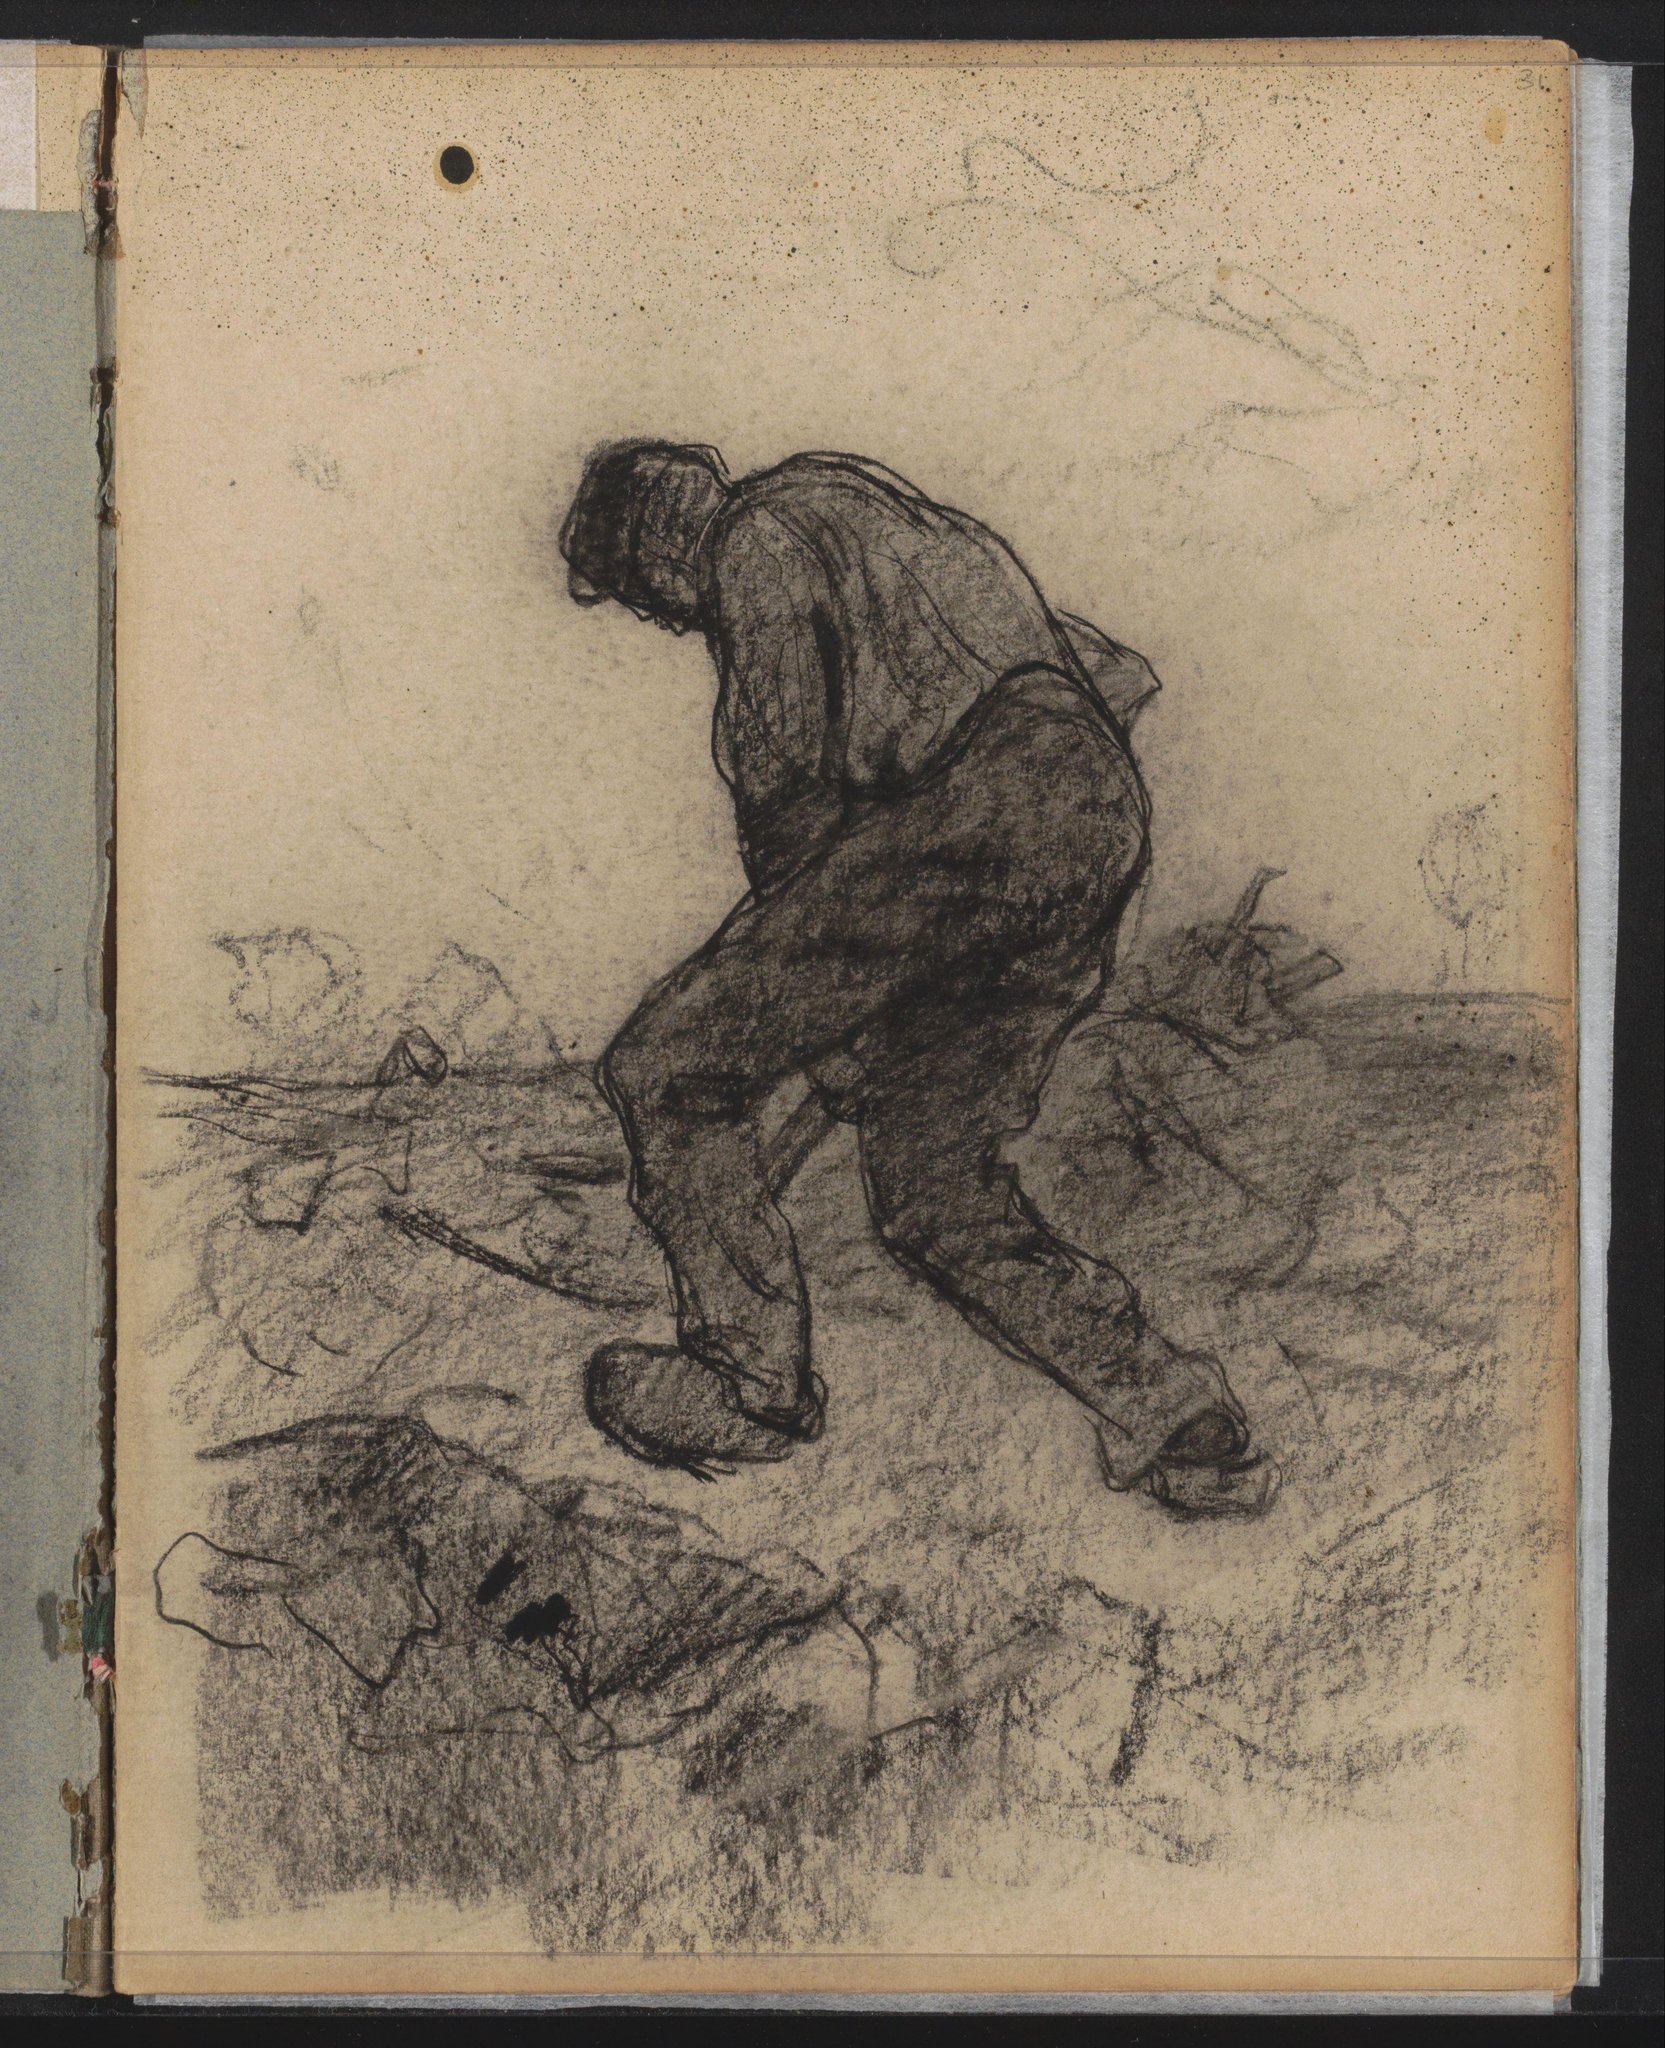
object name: sketchbook leaf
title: Heiwerker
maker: willem witsen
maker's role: draughtsman, painter, print maker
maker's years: 1860-1923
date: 1884-1888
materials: chalk, paper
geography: ewijkshoeve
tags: building-site (+ men (labourers))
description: Voorstudie voor de ets 'Heiwerker naar rechts', ca. 1888.